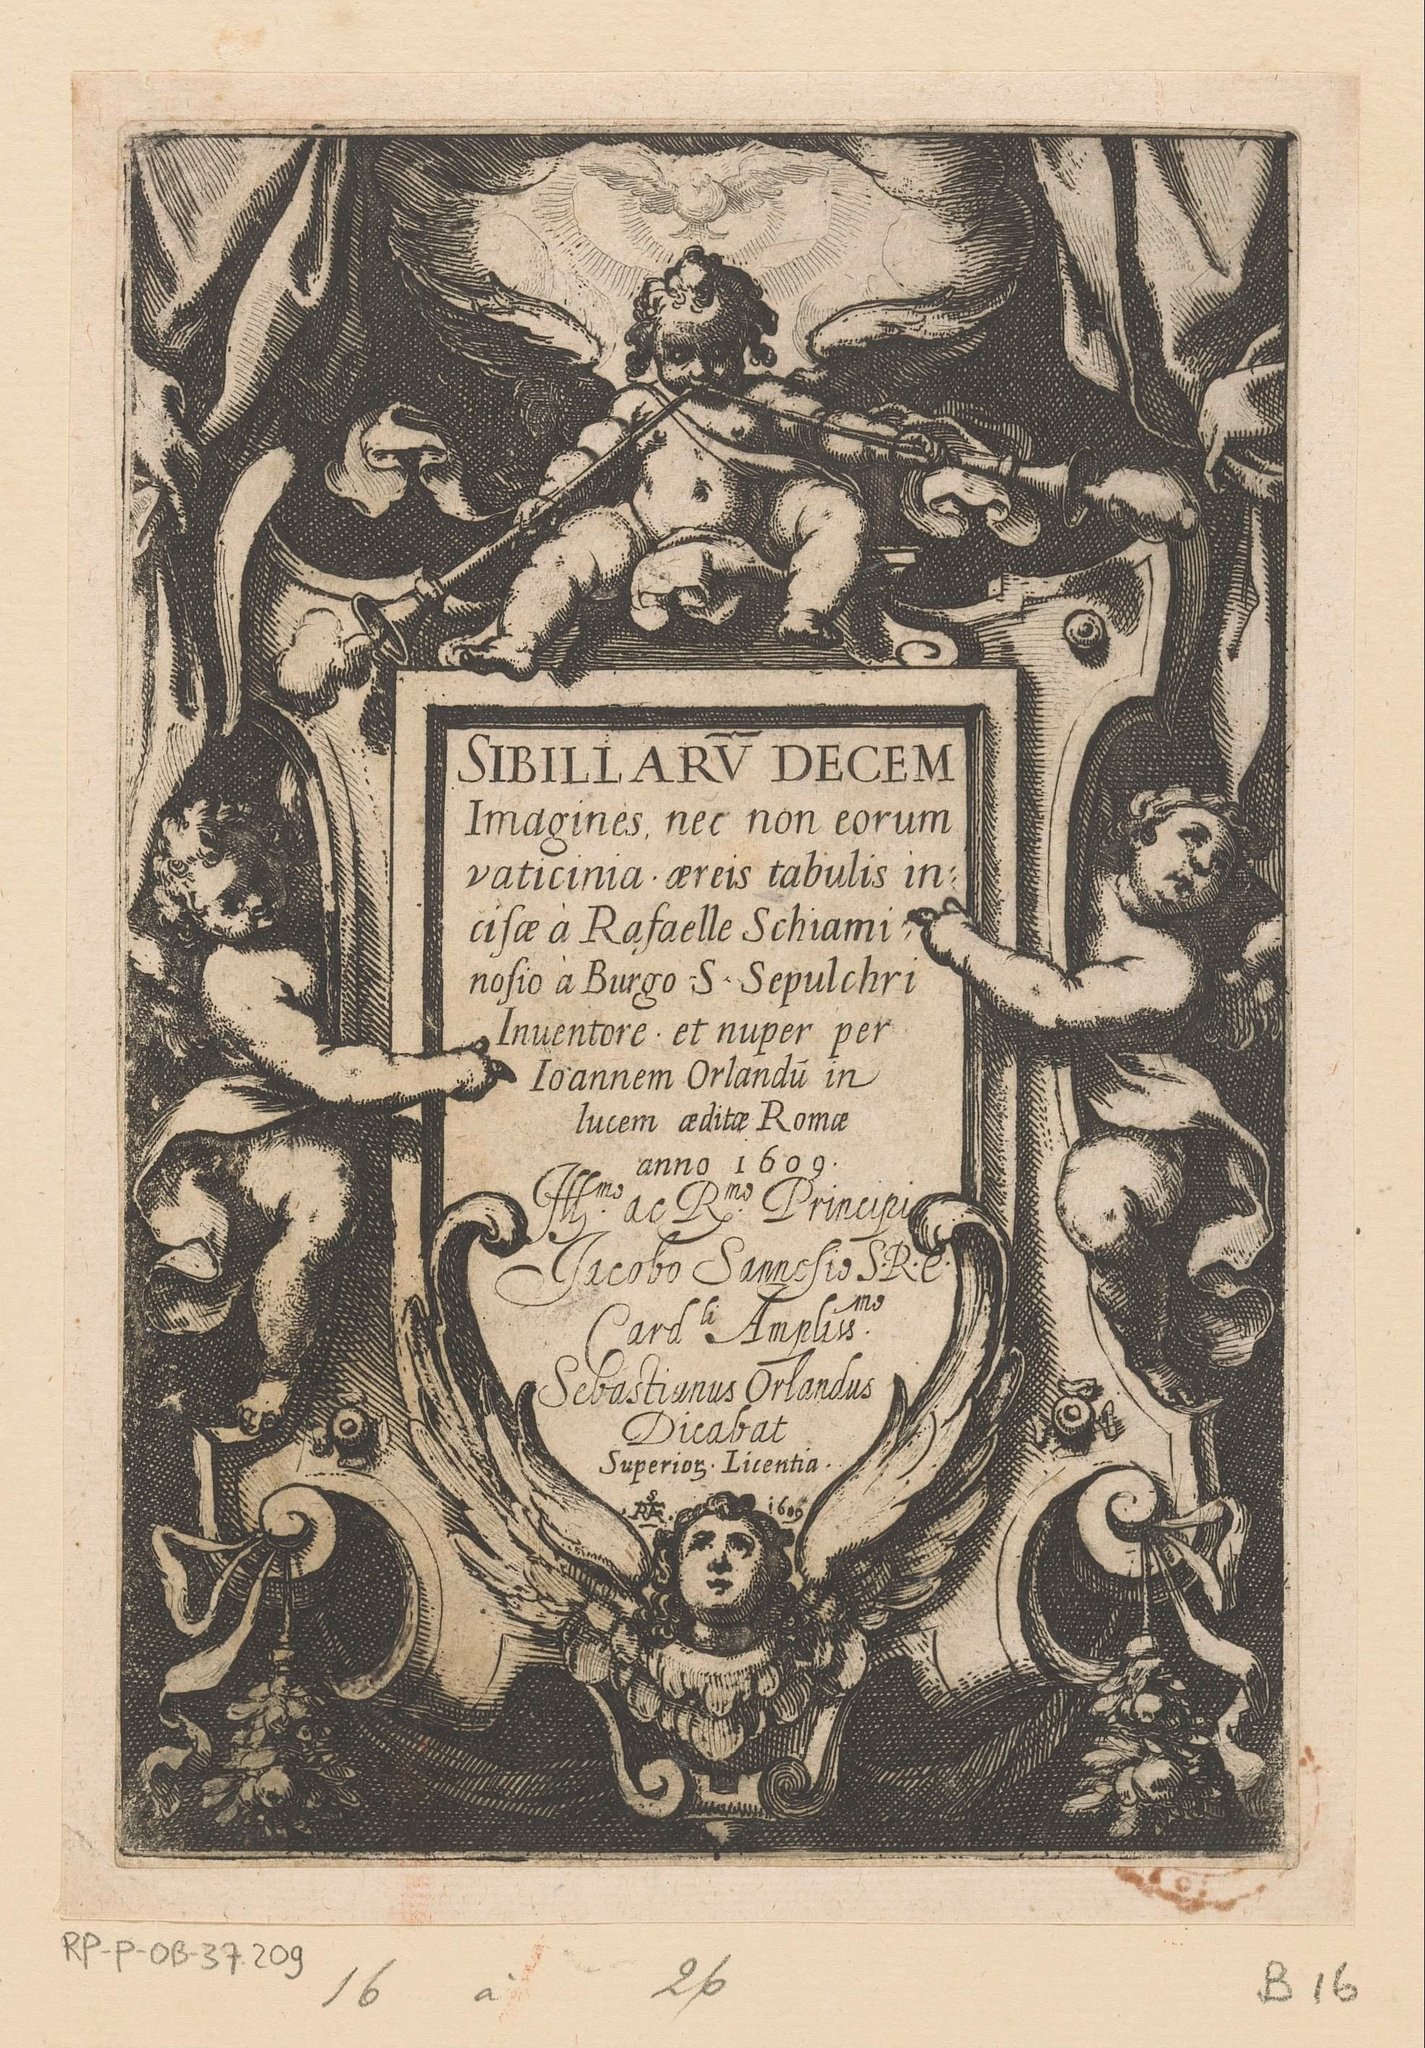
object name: print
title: Sibillaru decem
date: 1609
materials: paper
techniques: etching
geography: italy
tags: cherubs, i.e. children's heads with wings, fruits and vegetables ~ ornament, horn, trumpet, cornet, trombone, tuba, cupids: 'amores', 'amoretti', 'putti'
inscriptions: collector's mark: Lugt 240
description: Titelprent van een serie met voorstellingen van Sibillen die naast de titelprent bestaat uit tien prenten. De serie is driemaal uitgegeven: eenmaal in 1606 en tweemaal in 1609 (door Nicolaus van Aelst en door Giovanni Orlandi). Om deze reden worden de prenten uit deze serie hier 1606-1609 gedateerd, behalve indien de individuele prent zelf gedateerd is.